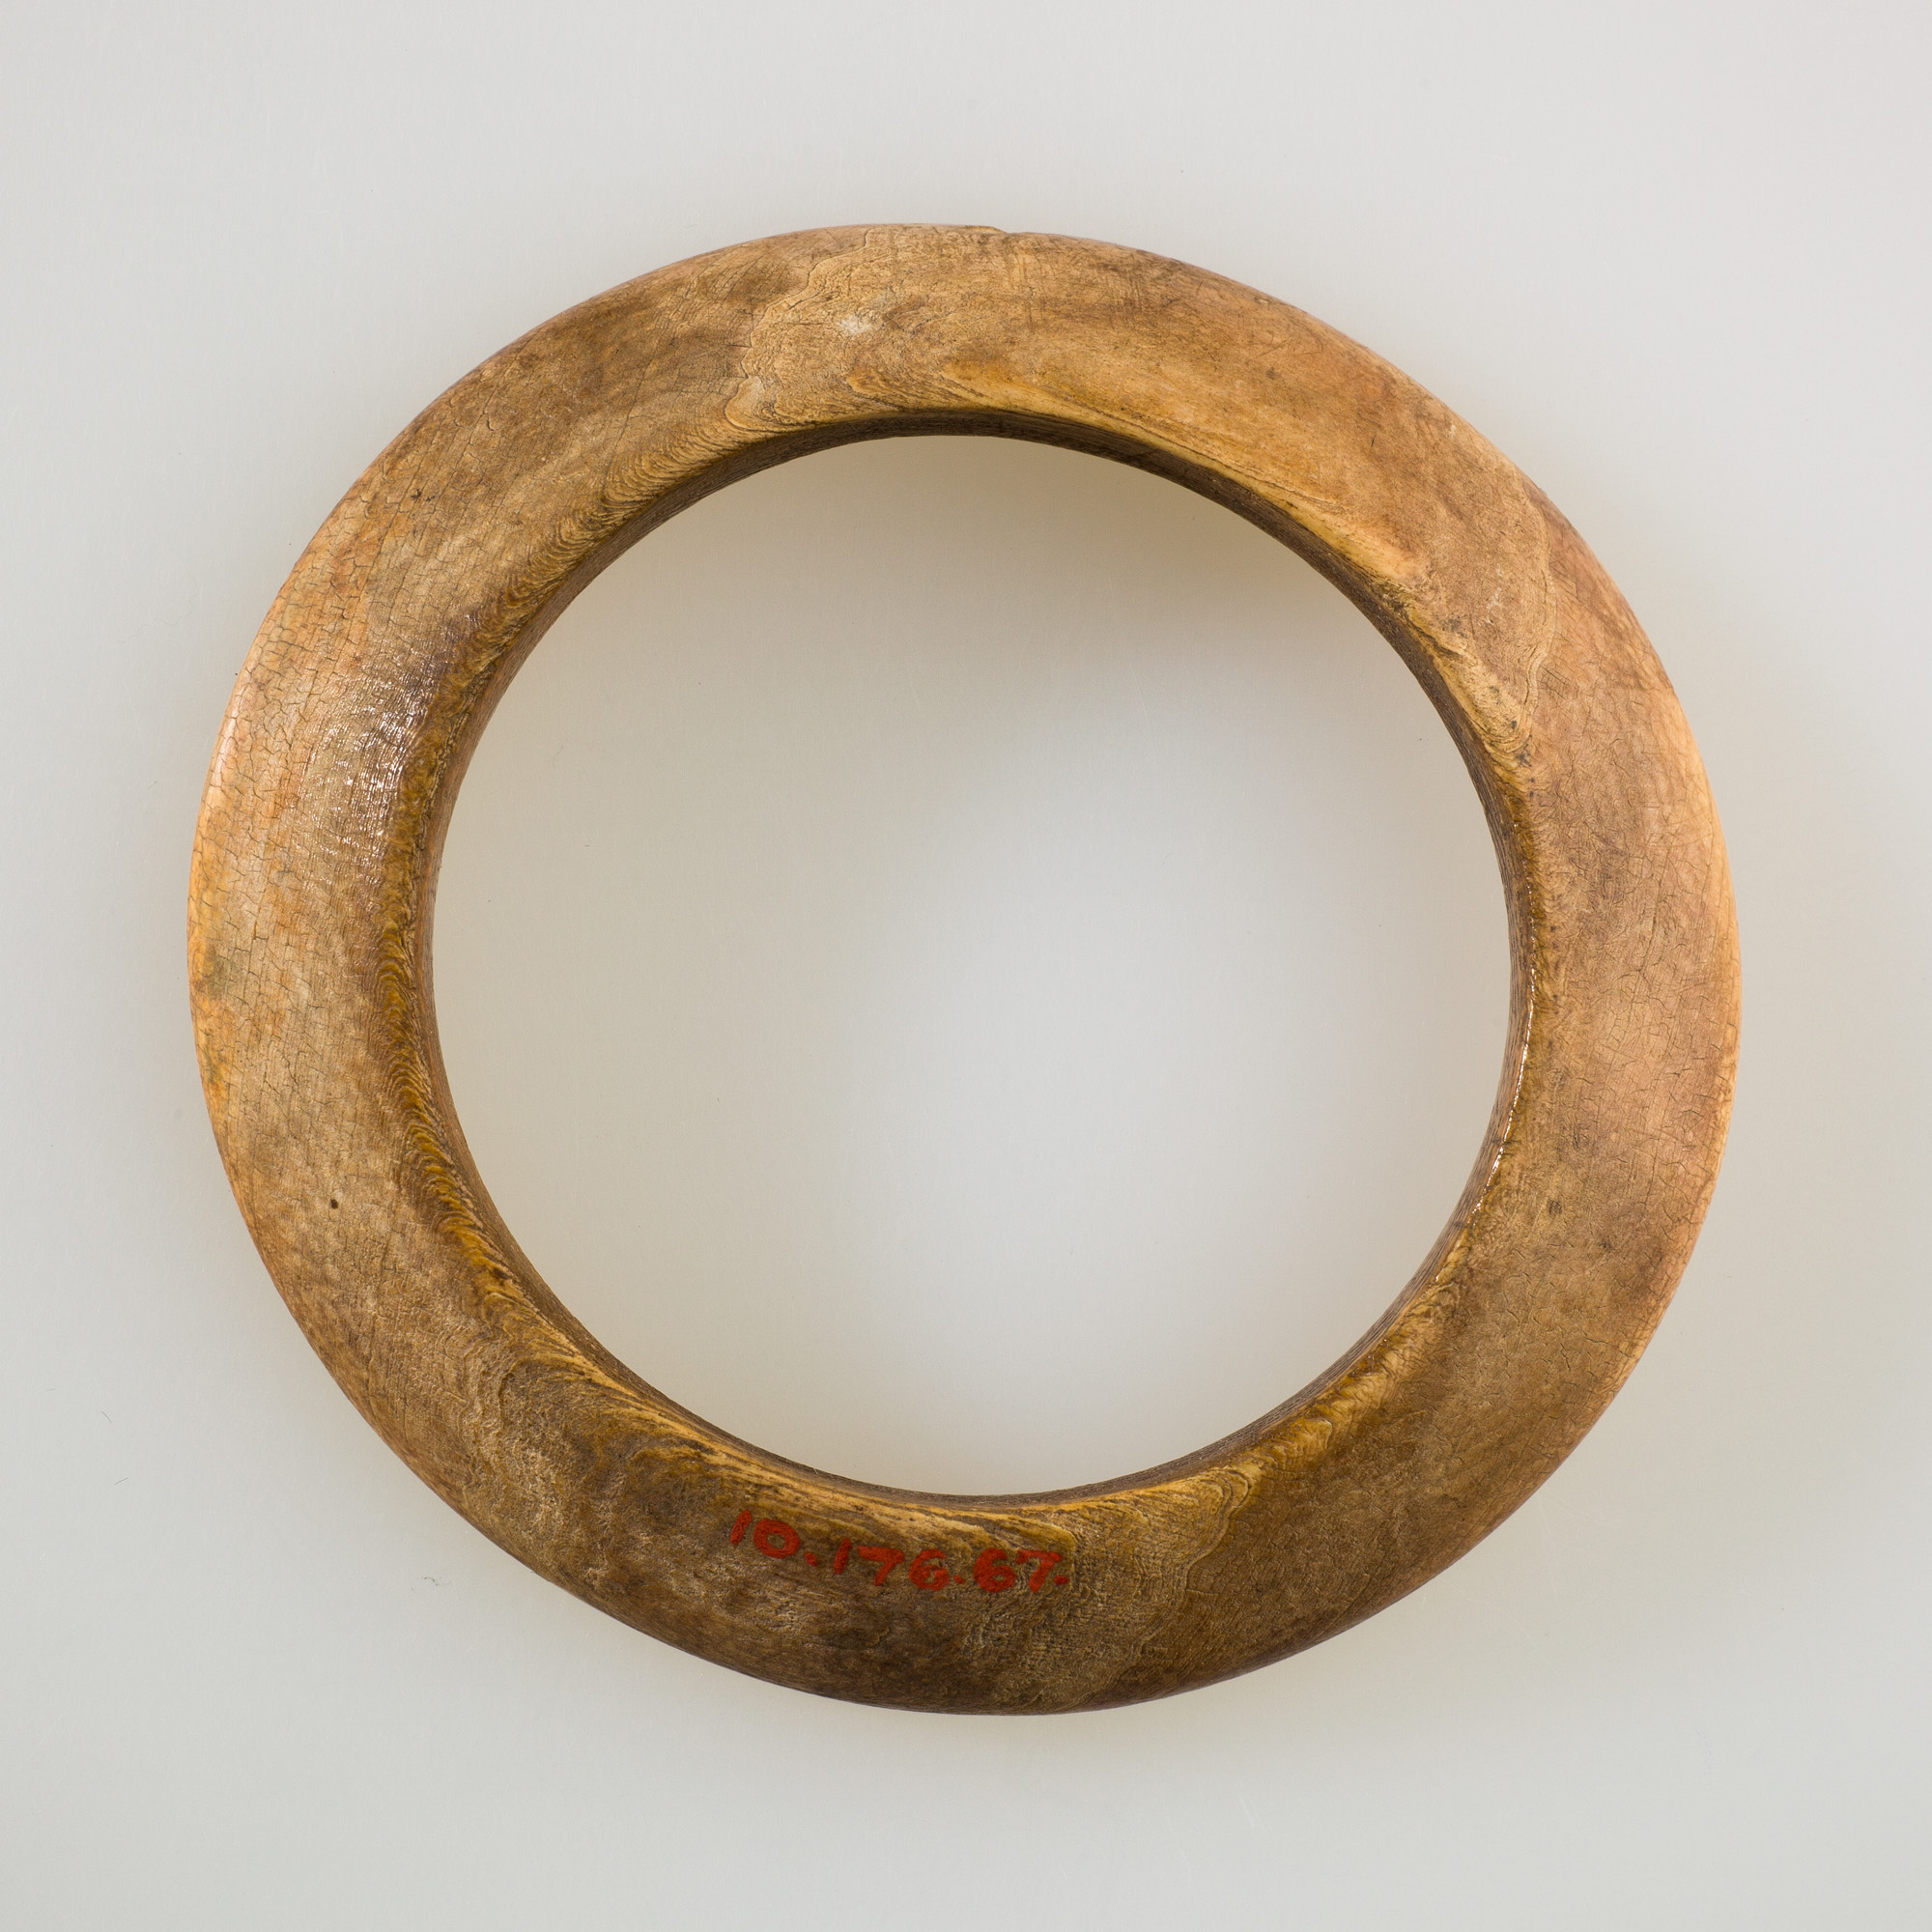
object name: bracelet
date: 3850-2960 BCE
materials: ivory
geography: egypt